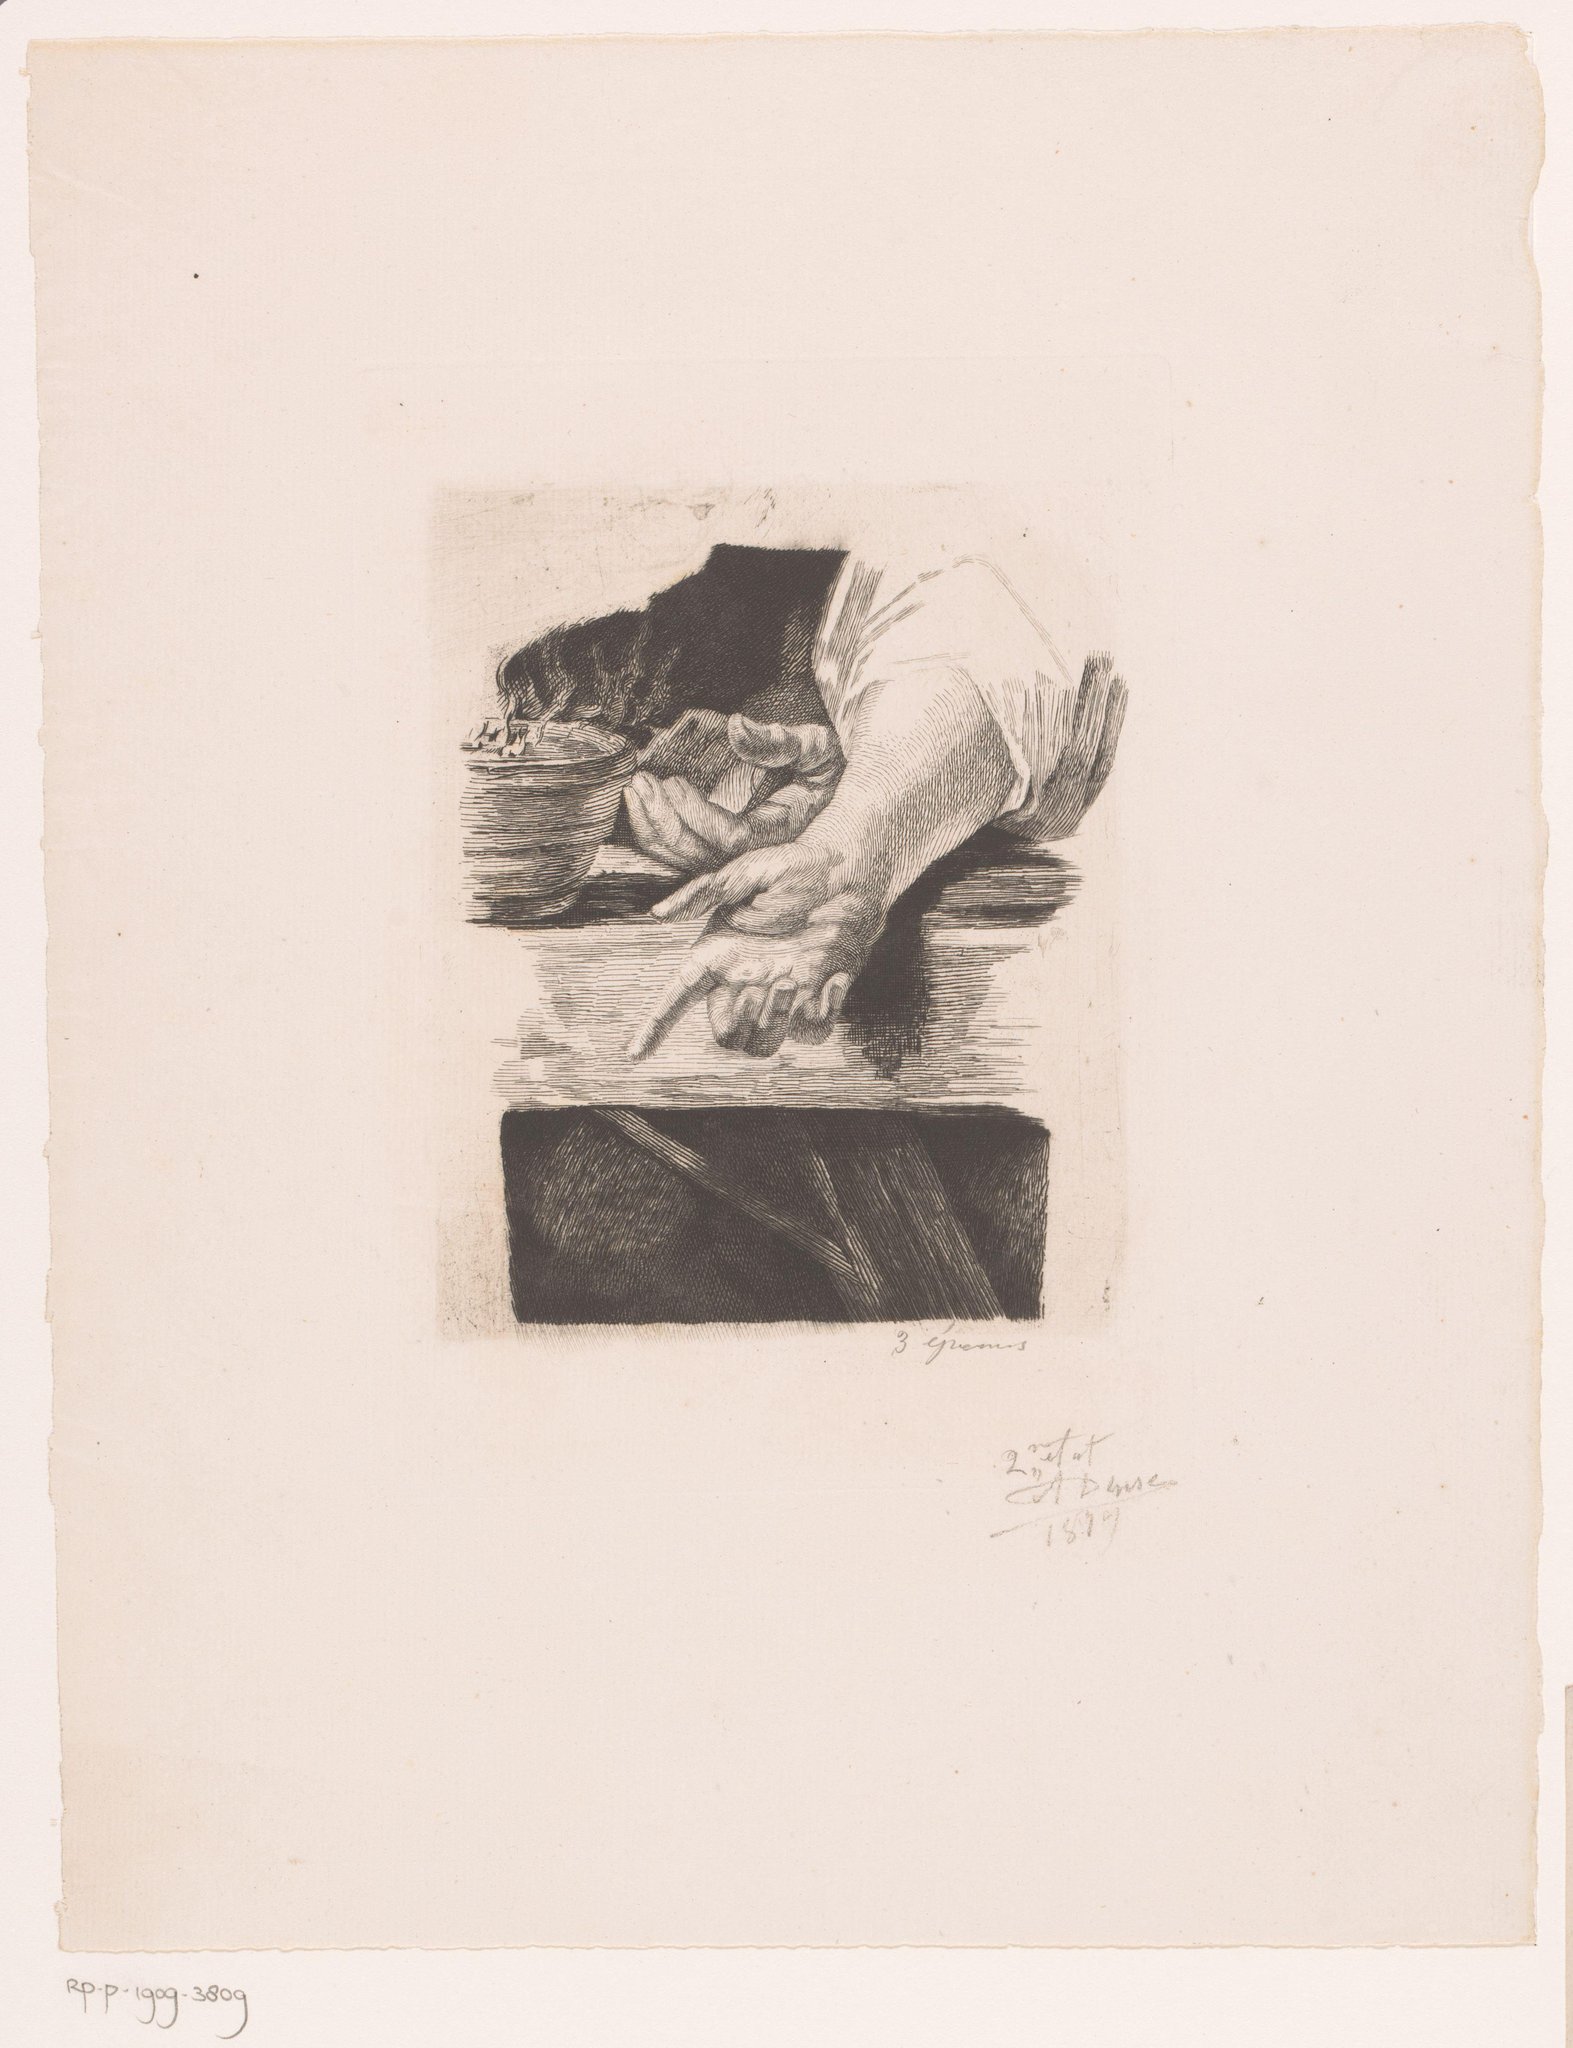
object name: print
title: Studie van twee handen op een tafel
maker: auguste danse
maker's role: print maker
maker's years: 1829-1929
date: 1879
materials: paper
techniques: drypoint, etching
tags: postures and gestures of arms and hands in general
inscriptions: collector's mark: Lugt 2228, annotation: ‘3 épreuves; 2me état’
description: Deze prent is een detail van het schilderij "Sater en Boer" door Jacob Jordaens.